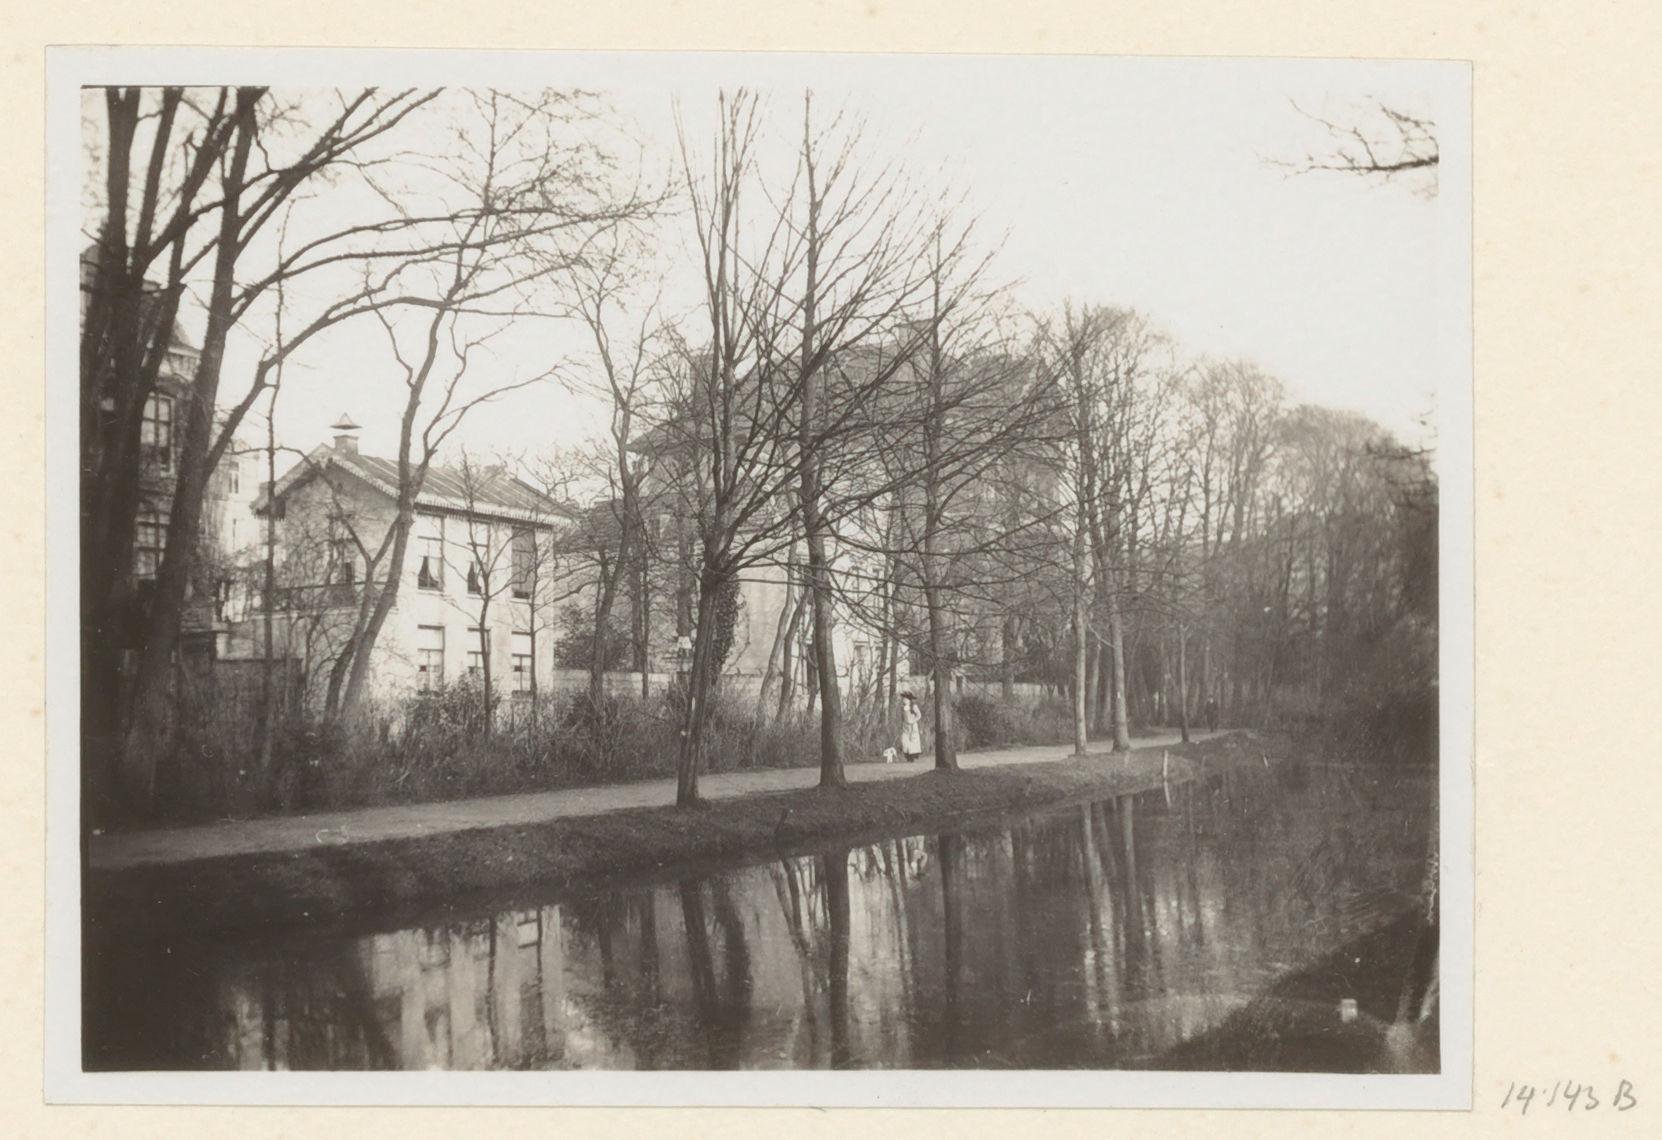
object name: photograph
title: Gezicht op het Zandpad langs het Vondelpark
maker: Anonymous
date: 1880-1950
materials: paper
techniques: gelatin silver print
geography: amsterdam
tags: park, city-view in general; 'veduta', canal, road, path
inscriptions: inscription: ‘Zandpad langs het Vondelpark / met de huishoudschool’, collector's mark: ‘14 143AB’ Lugt 1641b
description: Onderwerpsrubriek binnen de Atlas Amsterdam: Zaagmolensloot, Zandpad, Zeeburg, Zeeburgerdijk, Zeeburgerpad, Zeeburgerstraat, Zwanenburgwal, Zwartebijlsteeg.